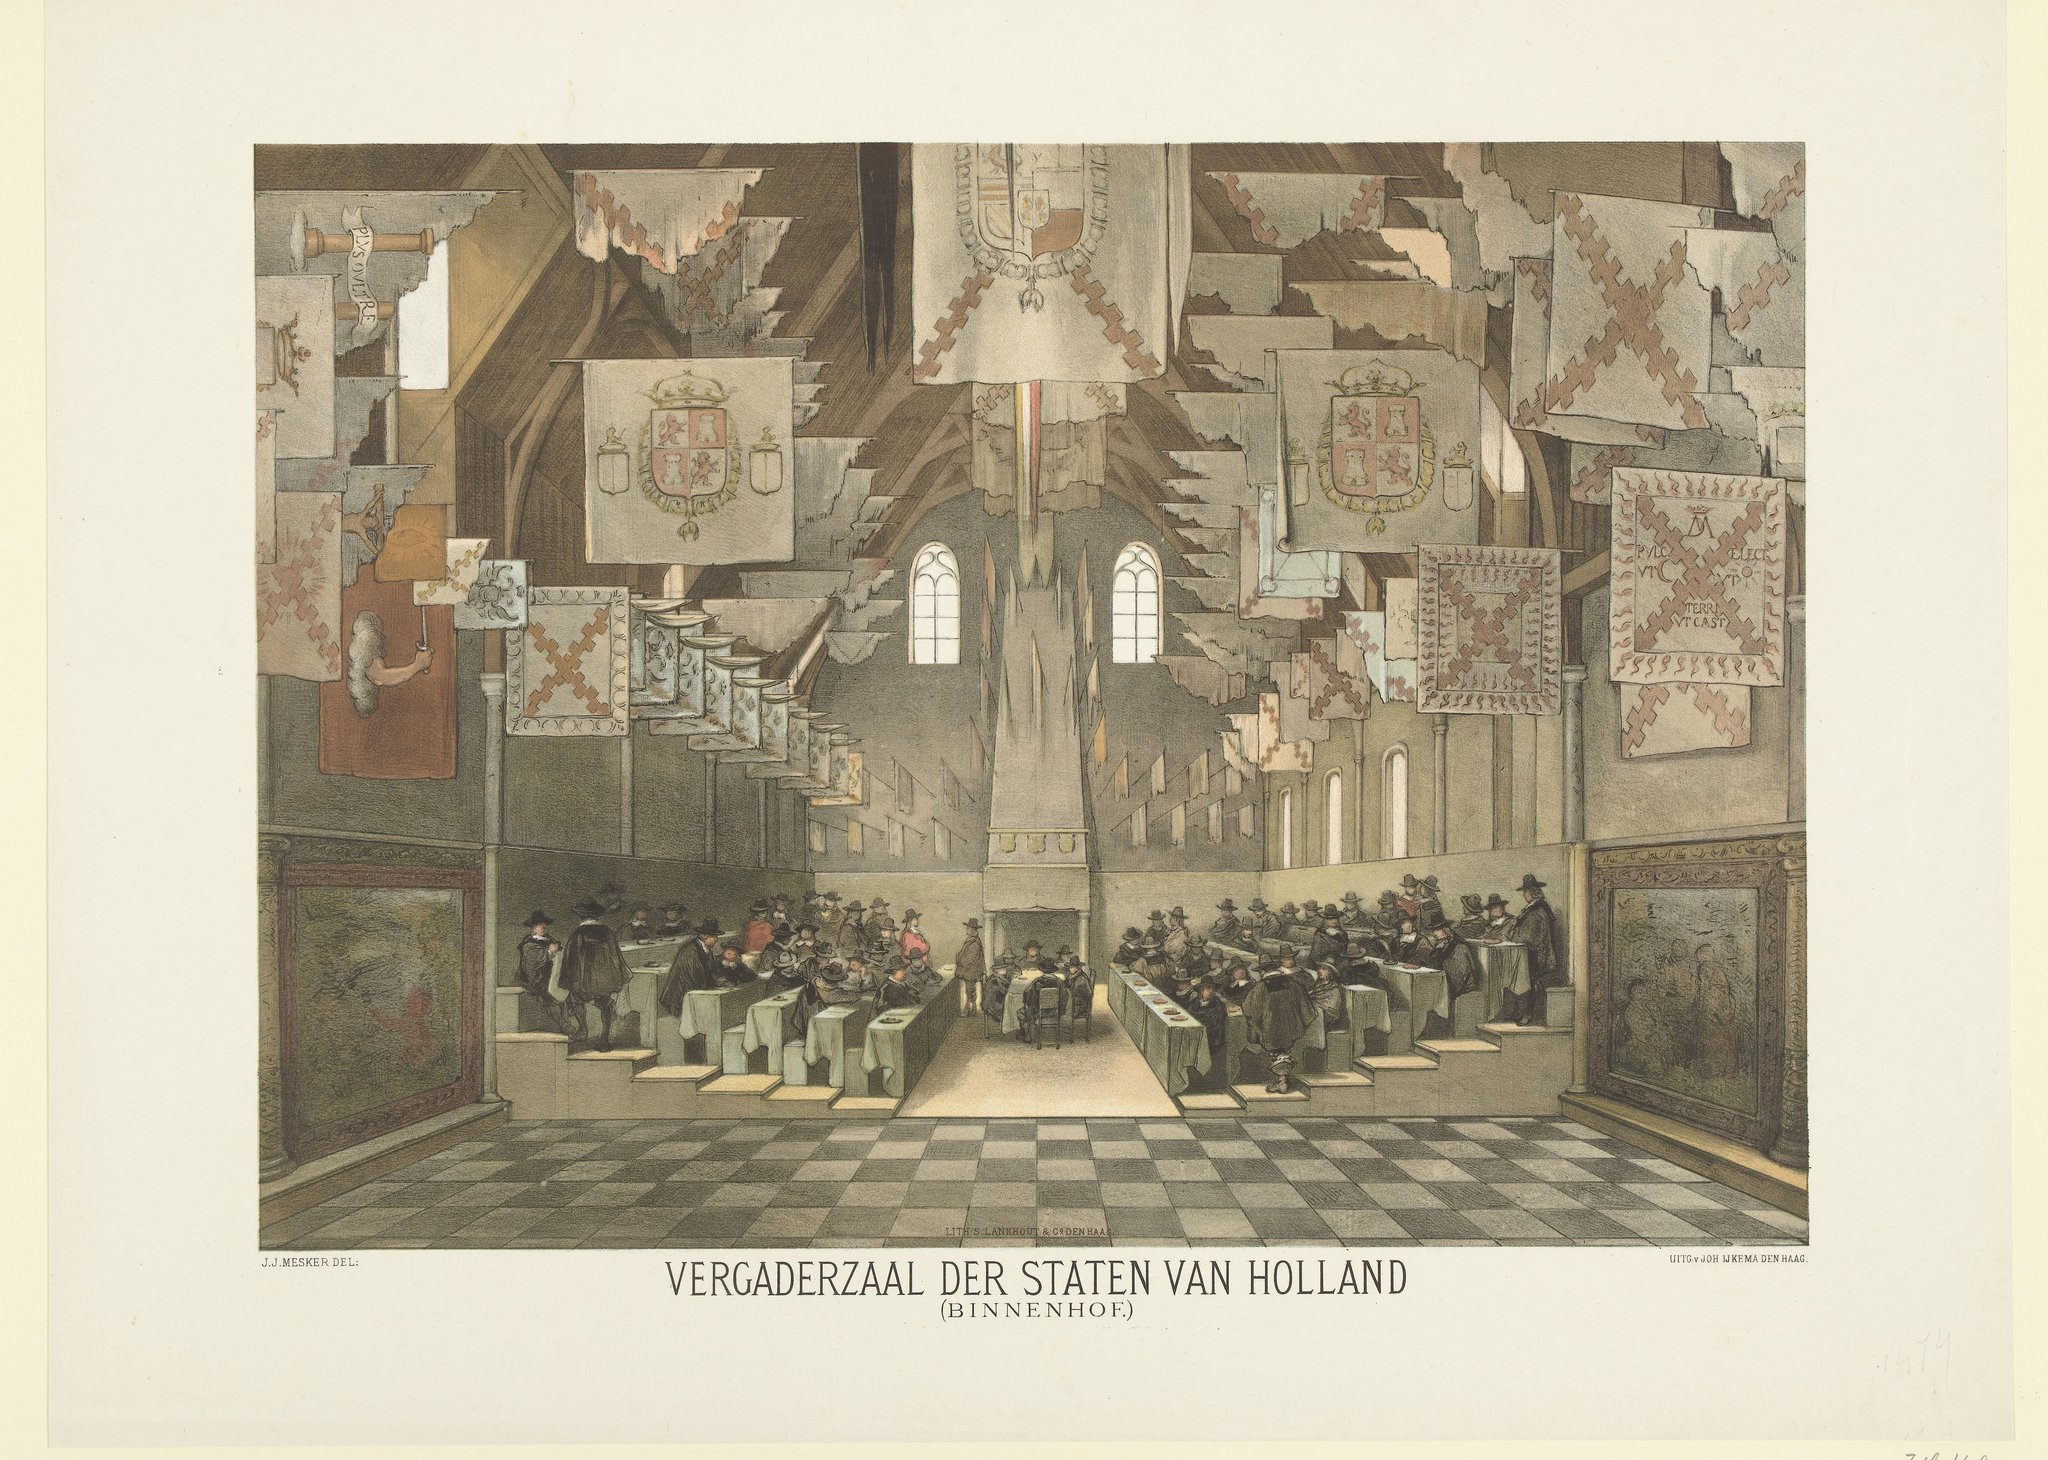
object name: history print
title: De grote zaal op het Binnenhof, Den Haag, tijdens de grote vergadering der Staten Generaal in 1651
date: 1878-1880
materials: paper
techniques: lithograph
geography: the hague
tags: meeting, assembly, (military) flags and standards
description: Interieur van de grote zaal op het Binnenhof, Den Haag, tijdens de grote vergadering van de Staten Generaal in 1651. Aan het plafond hangen op de vijand veroverde vlaggen en vaandels. Op de voorgrond staat een tafel met boeken, een zandloper en een inktstel. Op de tafel een kleed met de spreuk 'Concordia res parvae crescunt'.